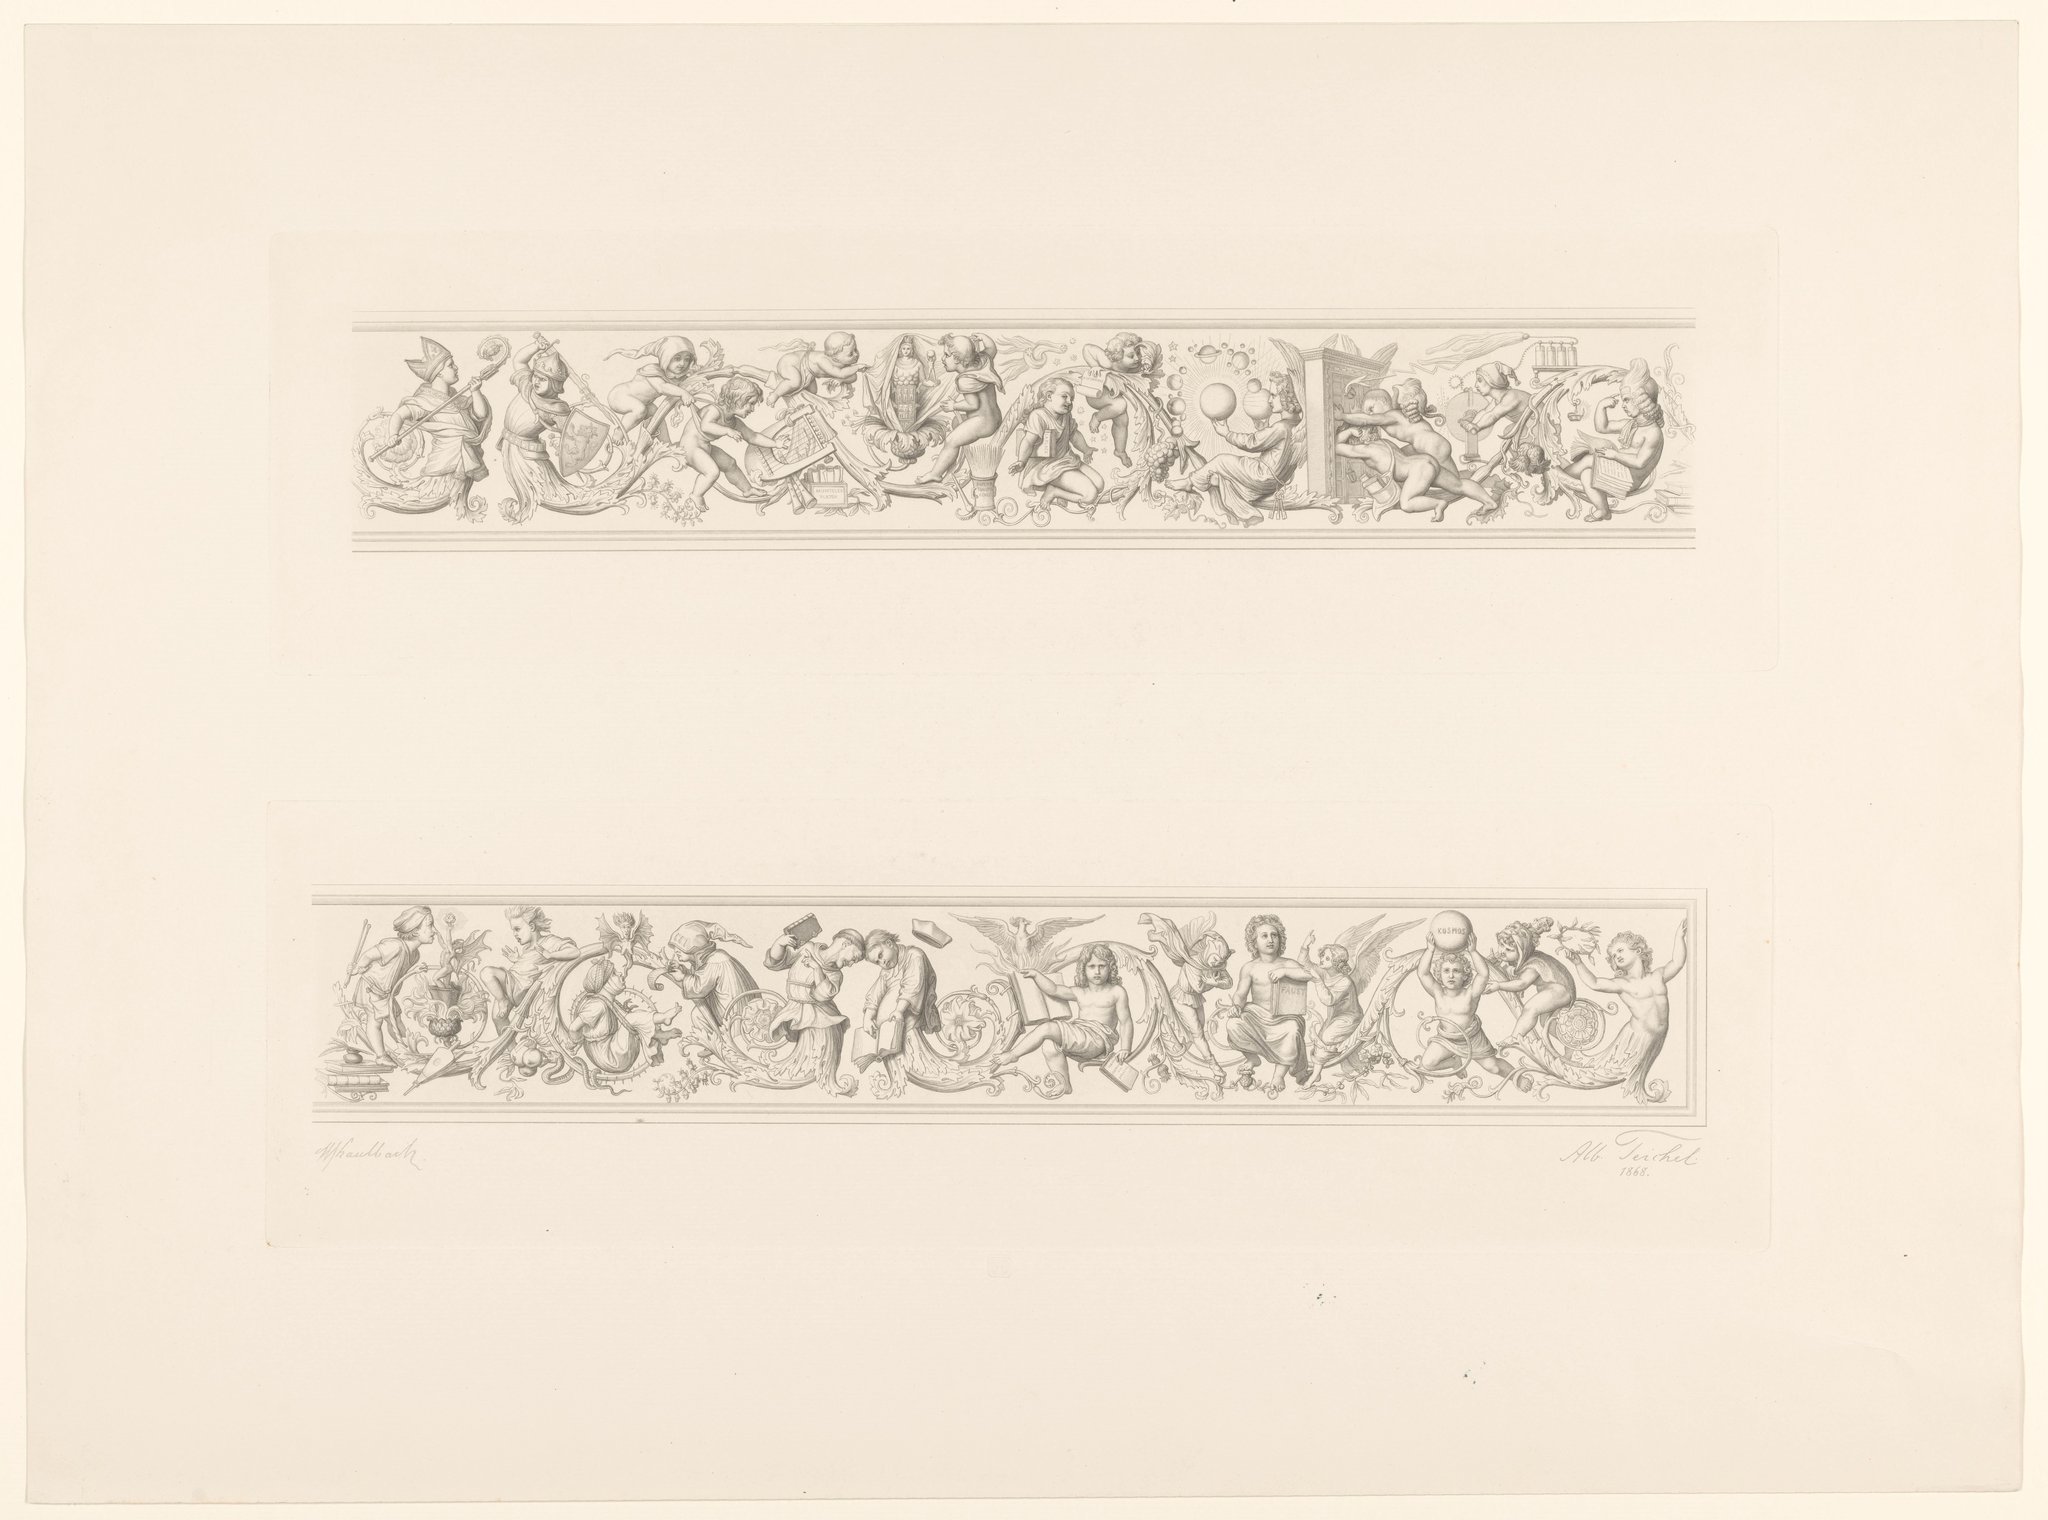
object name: print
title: Twee friezen met kinderen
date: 1868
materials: paper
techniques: engraving, etching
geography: germany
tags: anthropomorphic ornament, children's games and plays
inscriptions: collector's mark: Lugt 2165